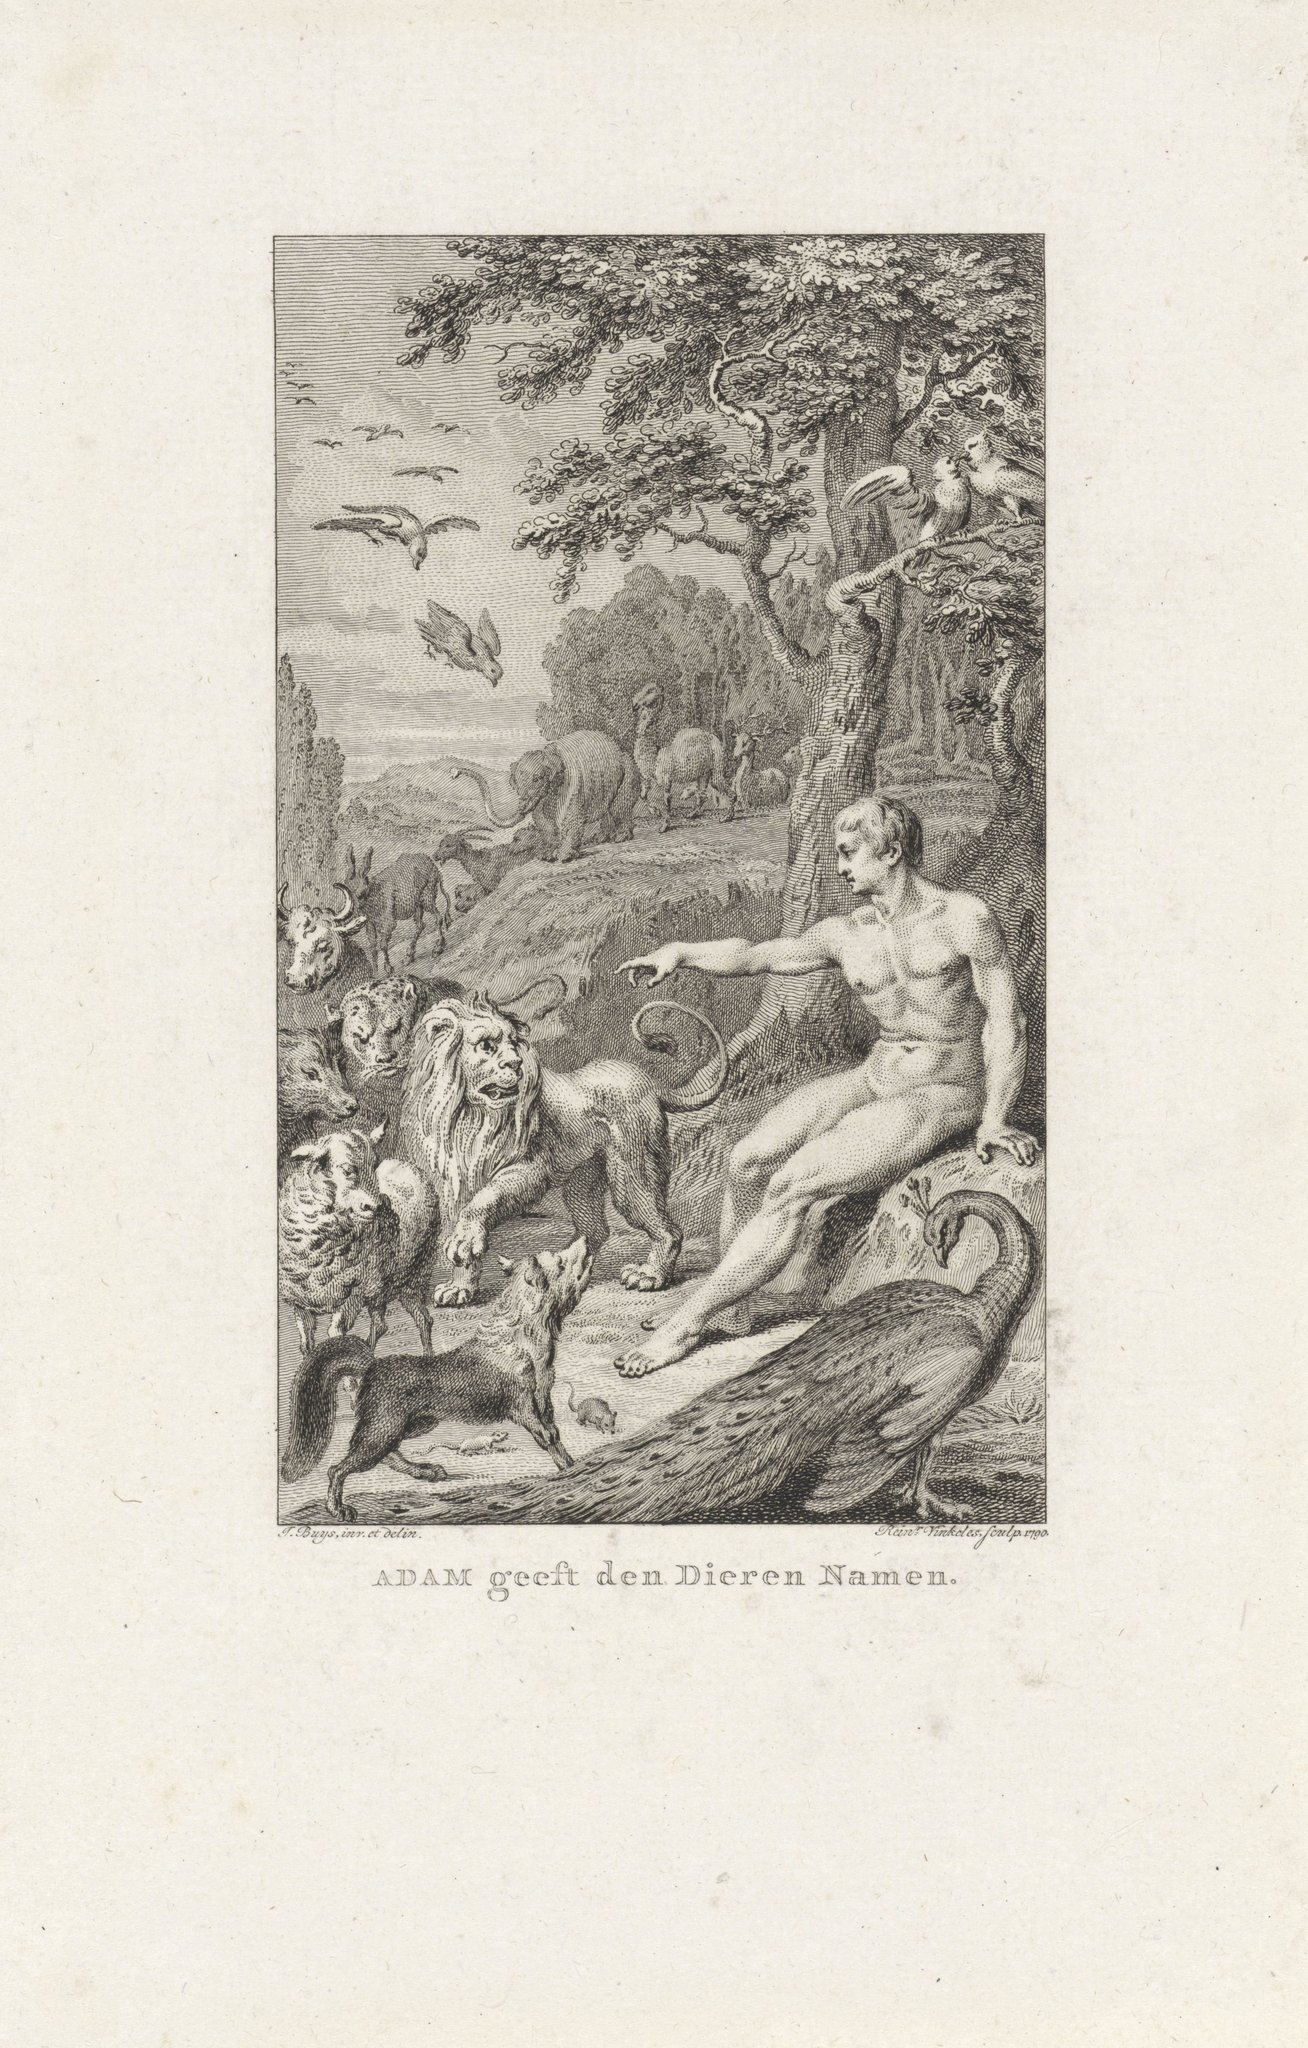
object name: print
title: Adam geeft de dieren hun namen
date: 1790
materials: paper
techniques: engraving, etching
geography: amsterdam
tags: adam naming the animals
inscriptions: collector's mark: Lugt 240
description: Adam zit onder een boom en geeft de dieren hun namen.